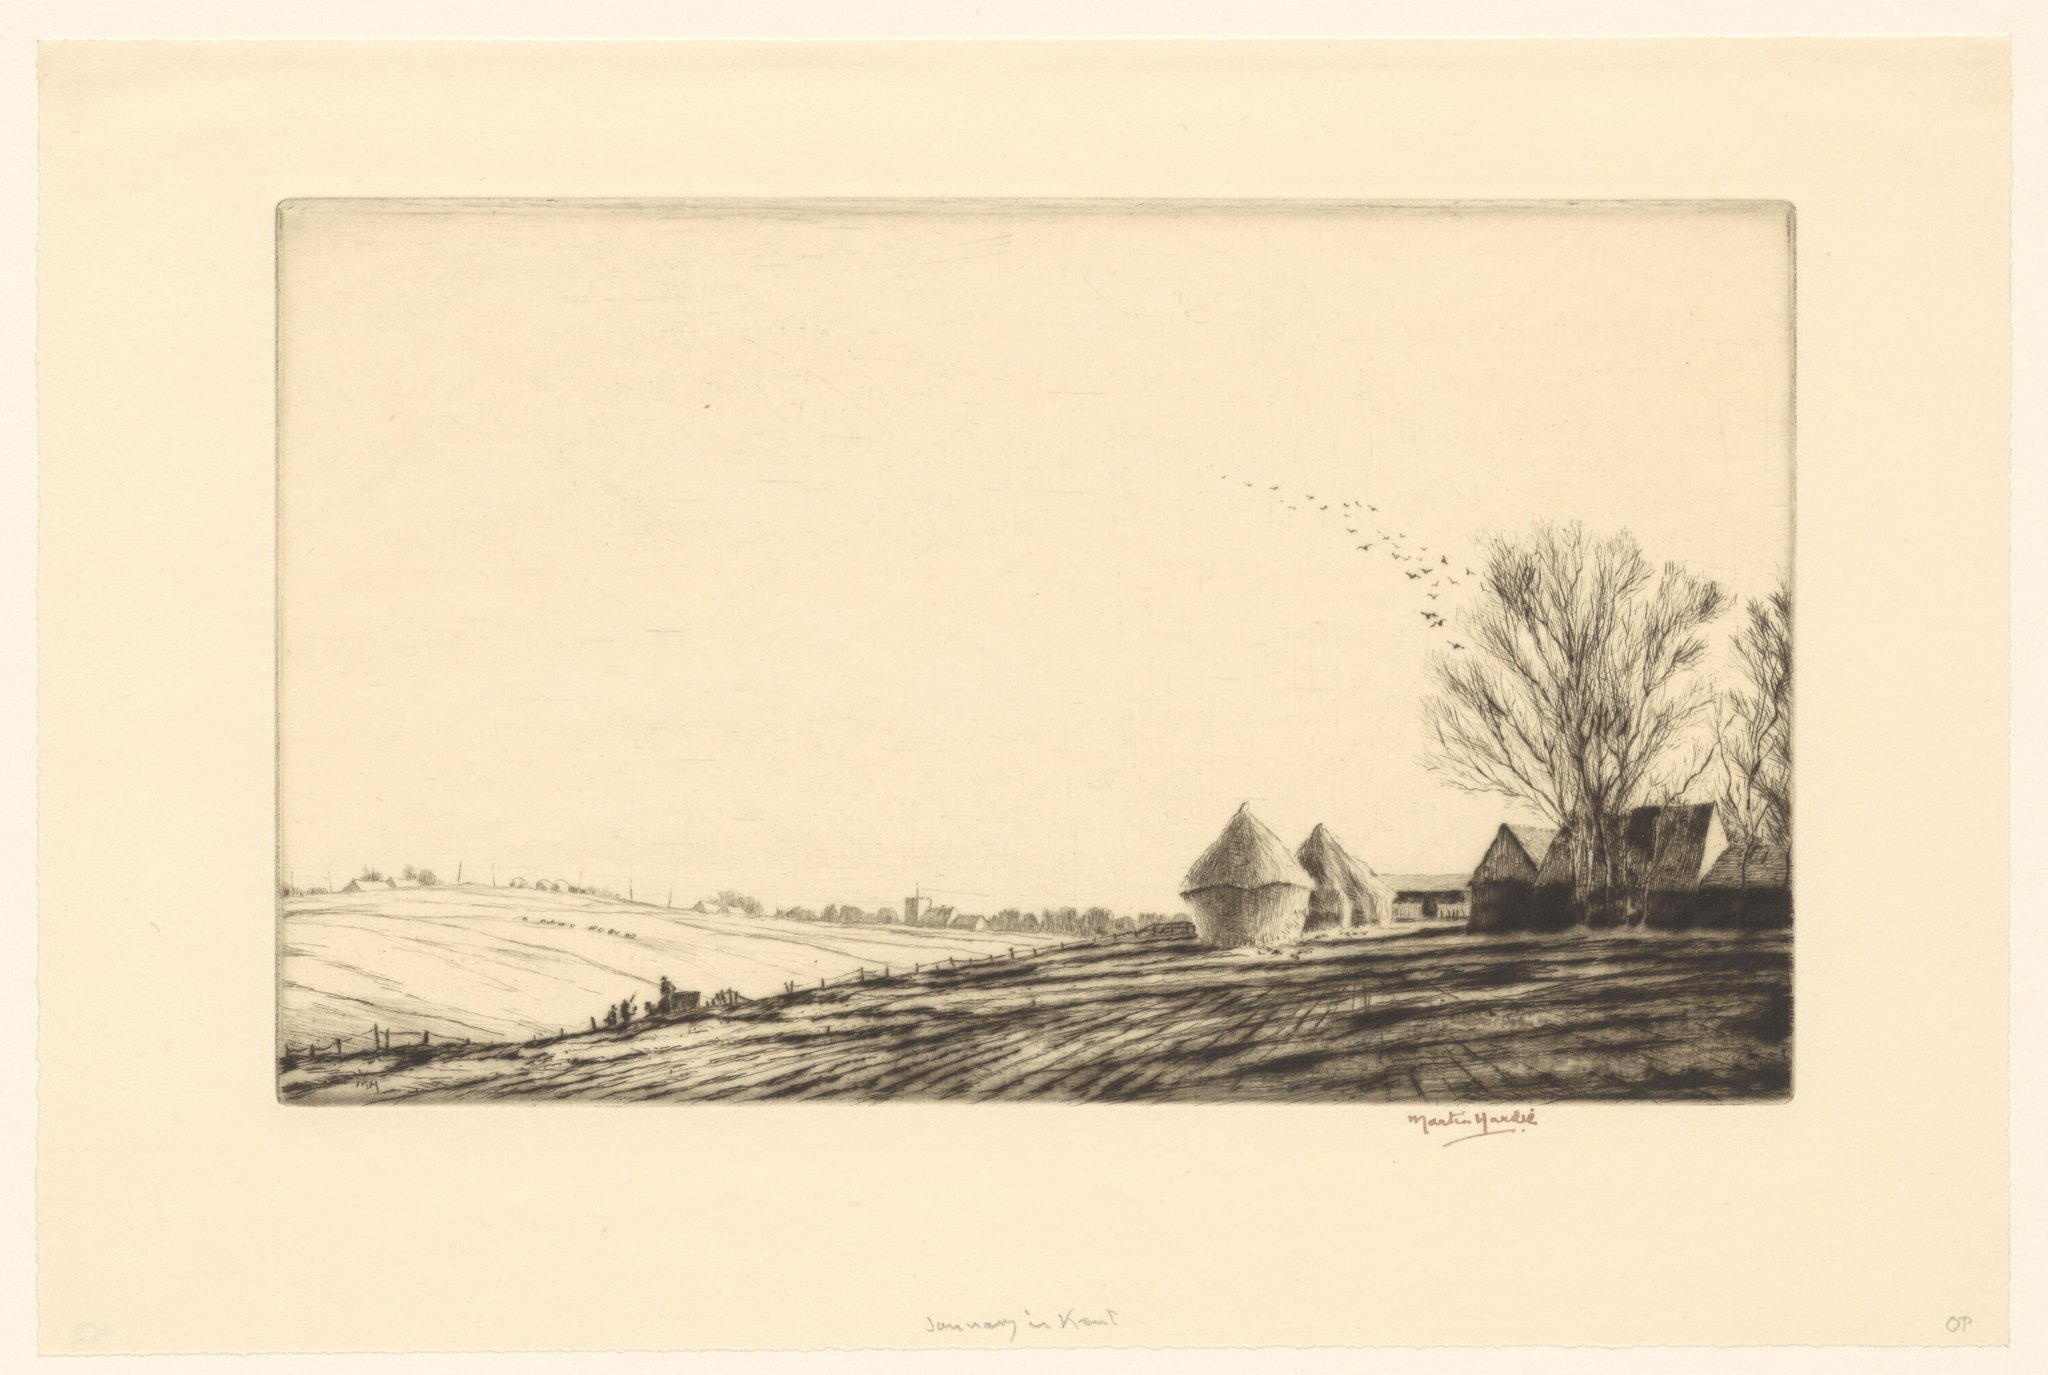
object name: print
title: Winterlandschap met boerderijen en hooibergen nabij St Margaret-at-Cliffe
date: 1934-1945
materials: paper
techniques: drypoint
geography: kent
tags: farm or solitary house in landscape, meadow, pasture (+ landscape with figures, staffage)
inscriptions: annotation: ‘Martin Hardie’, collector's mark: Lugt 2228, collector's mark: Lugt 2760